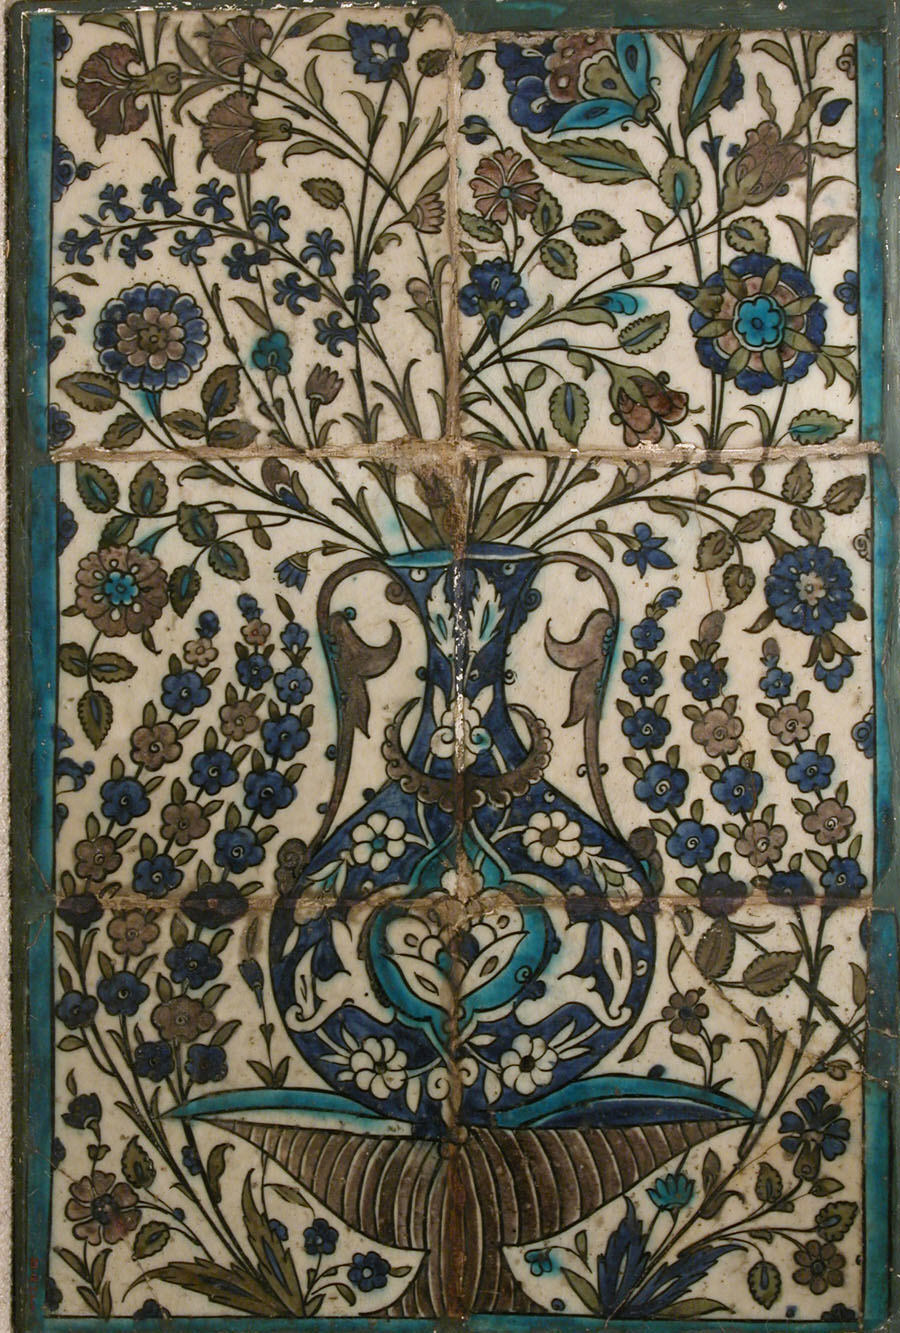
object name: tile panel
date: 1501-1700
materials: stonepaste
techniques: painting, underglaze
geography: syria